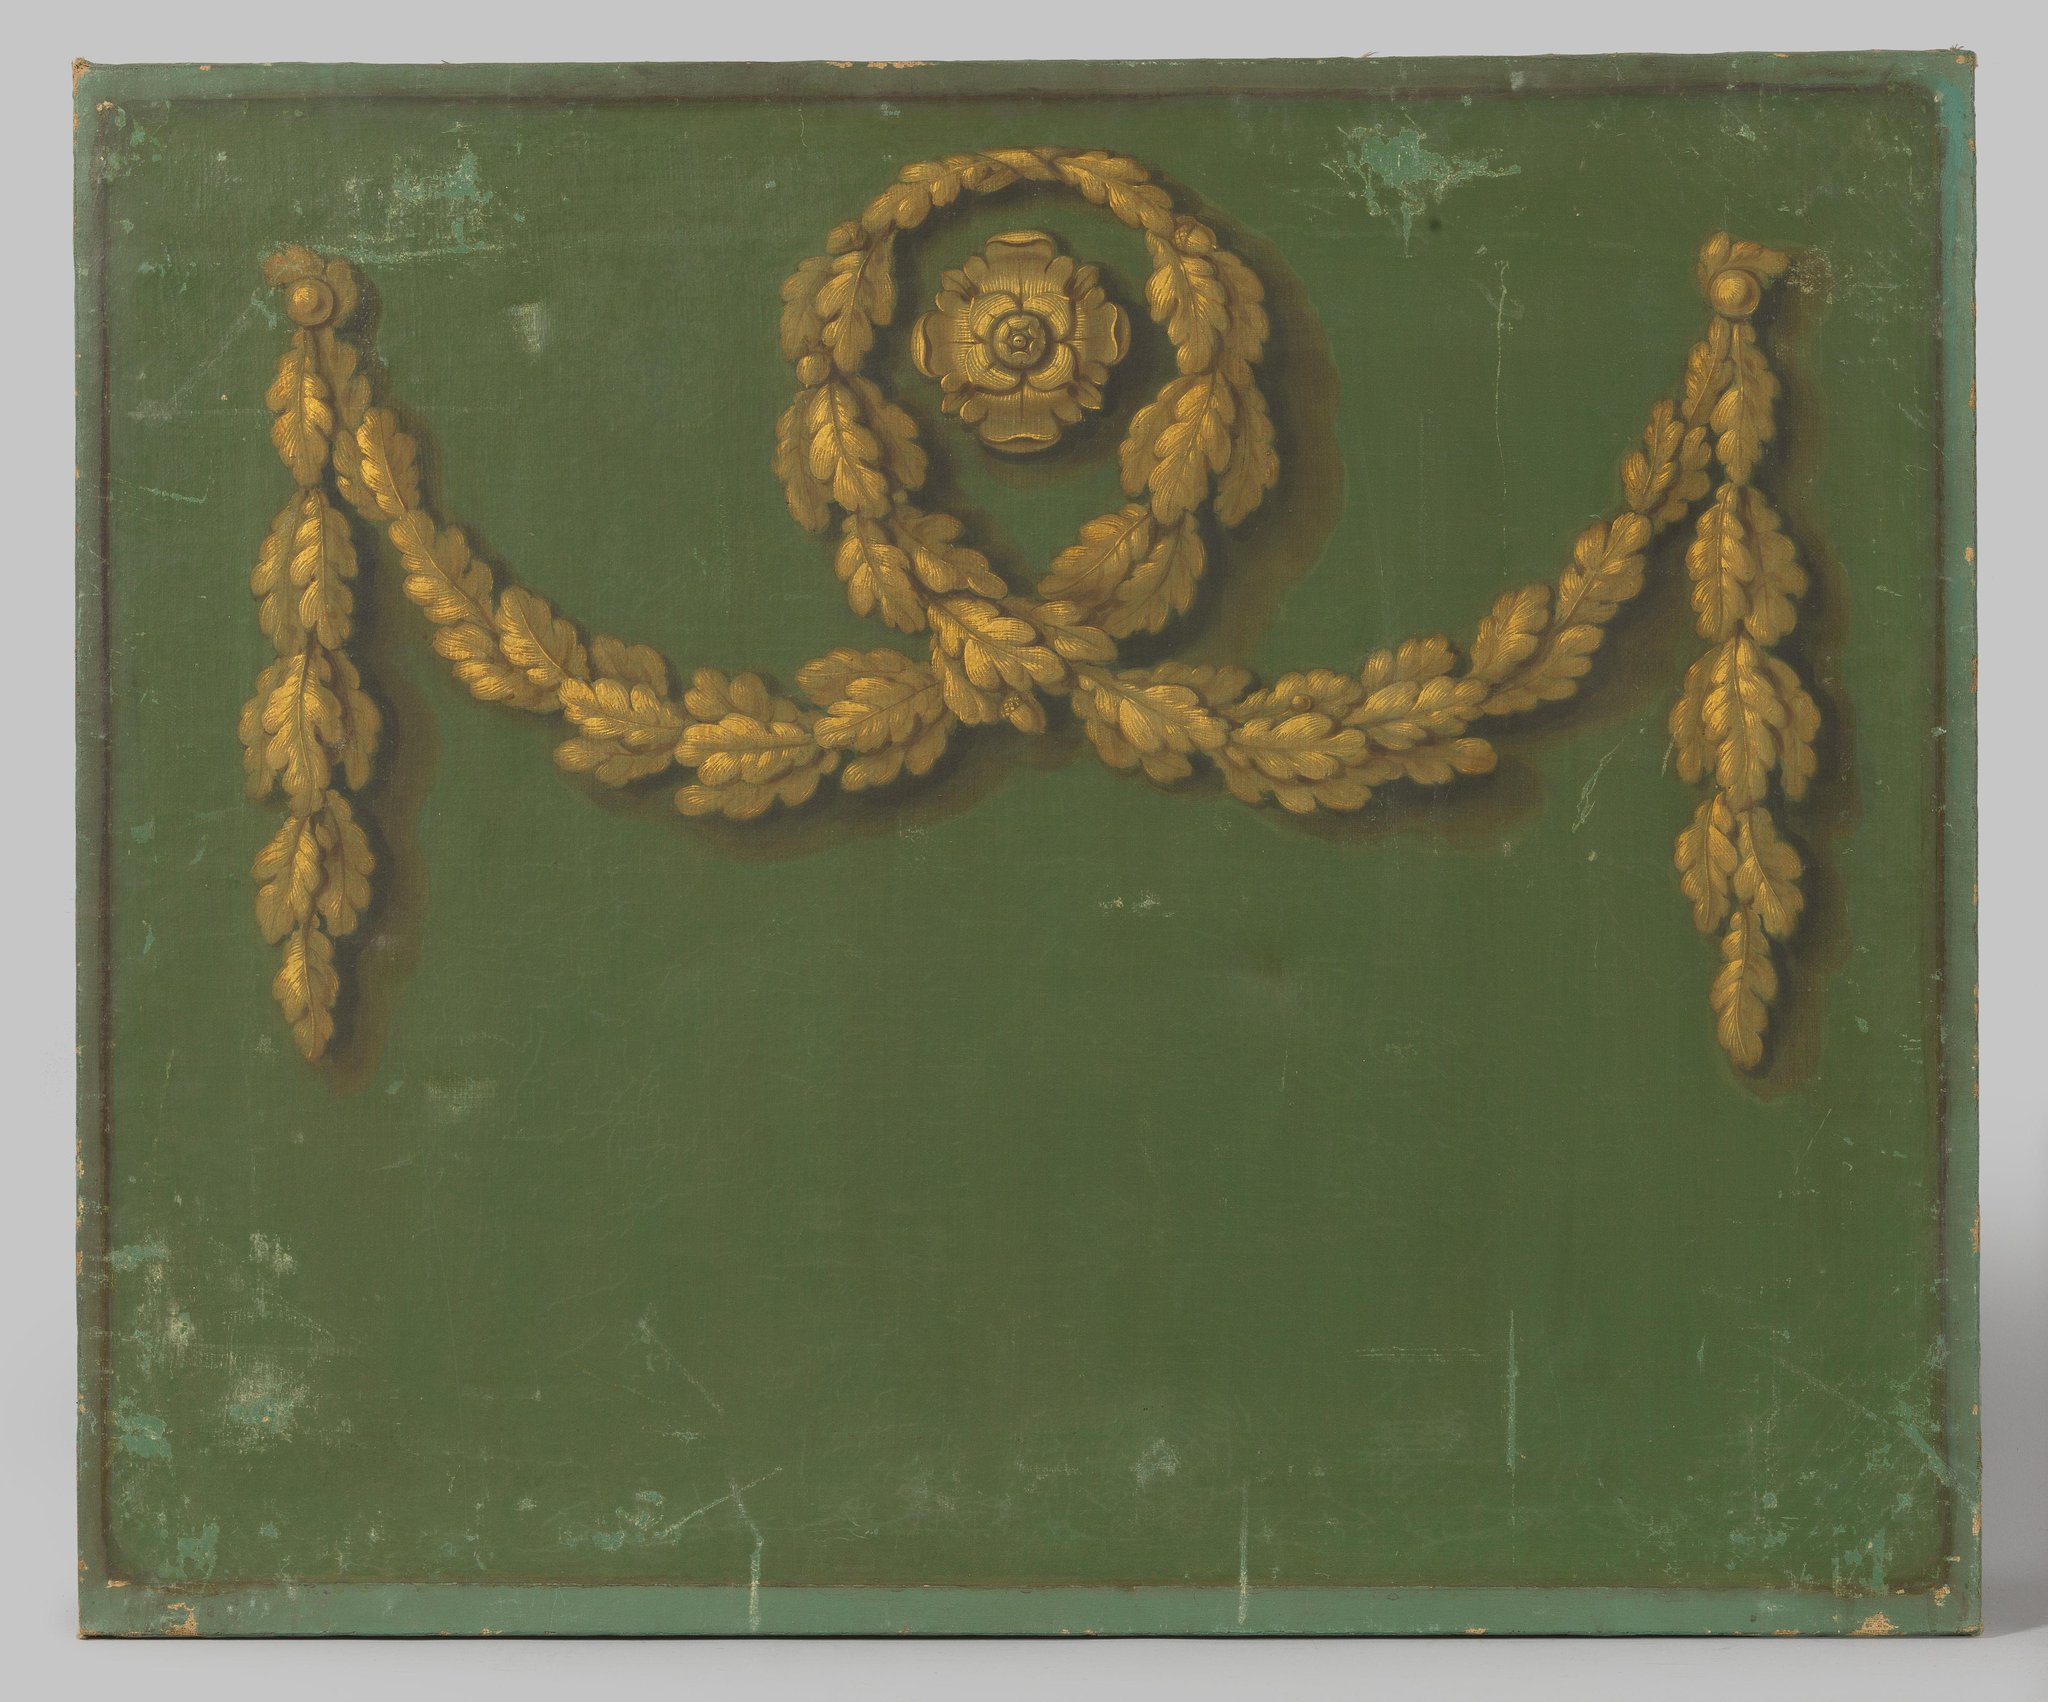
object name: hanging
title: Behang, op doek beschilderd in goud op groen met bladkransen. Onderdeel van betimmering van de Nederlandse Middenstandsbank, Herengracht 580 te Amsterdam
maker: Anonymous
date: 1790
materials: linen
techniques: painted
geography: northern netherlands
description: Behangsel dat op een groen fond gouden bladkransen vertoont. Het behangsel maakt deel uit van een olijfgroen met goud beschilderde betimmering. Zie tevens: BK-1957-72 en BK-1957-72-a/e en g/i.